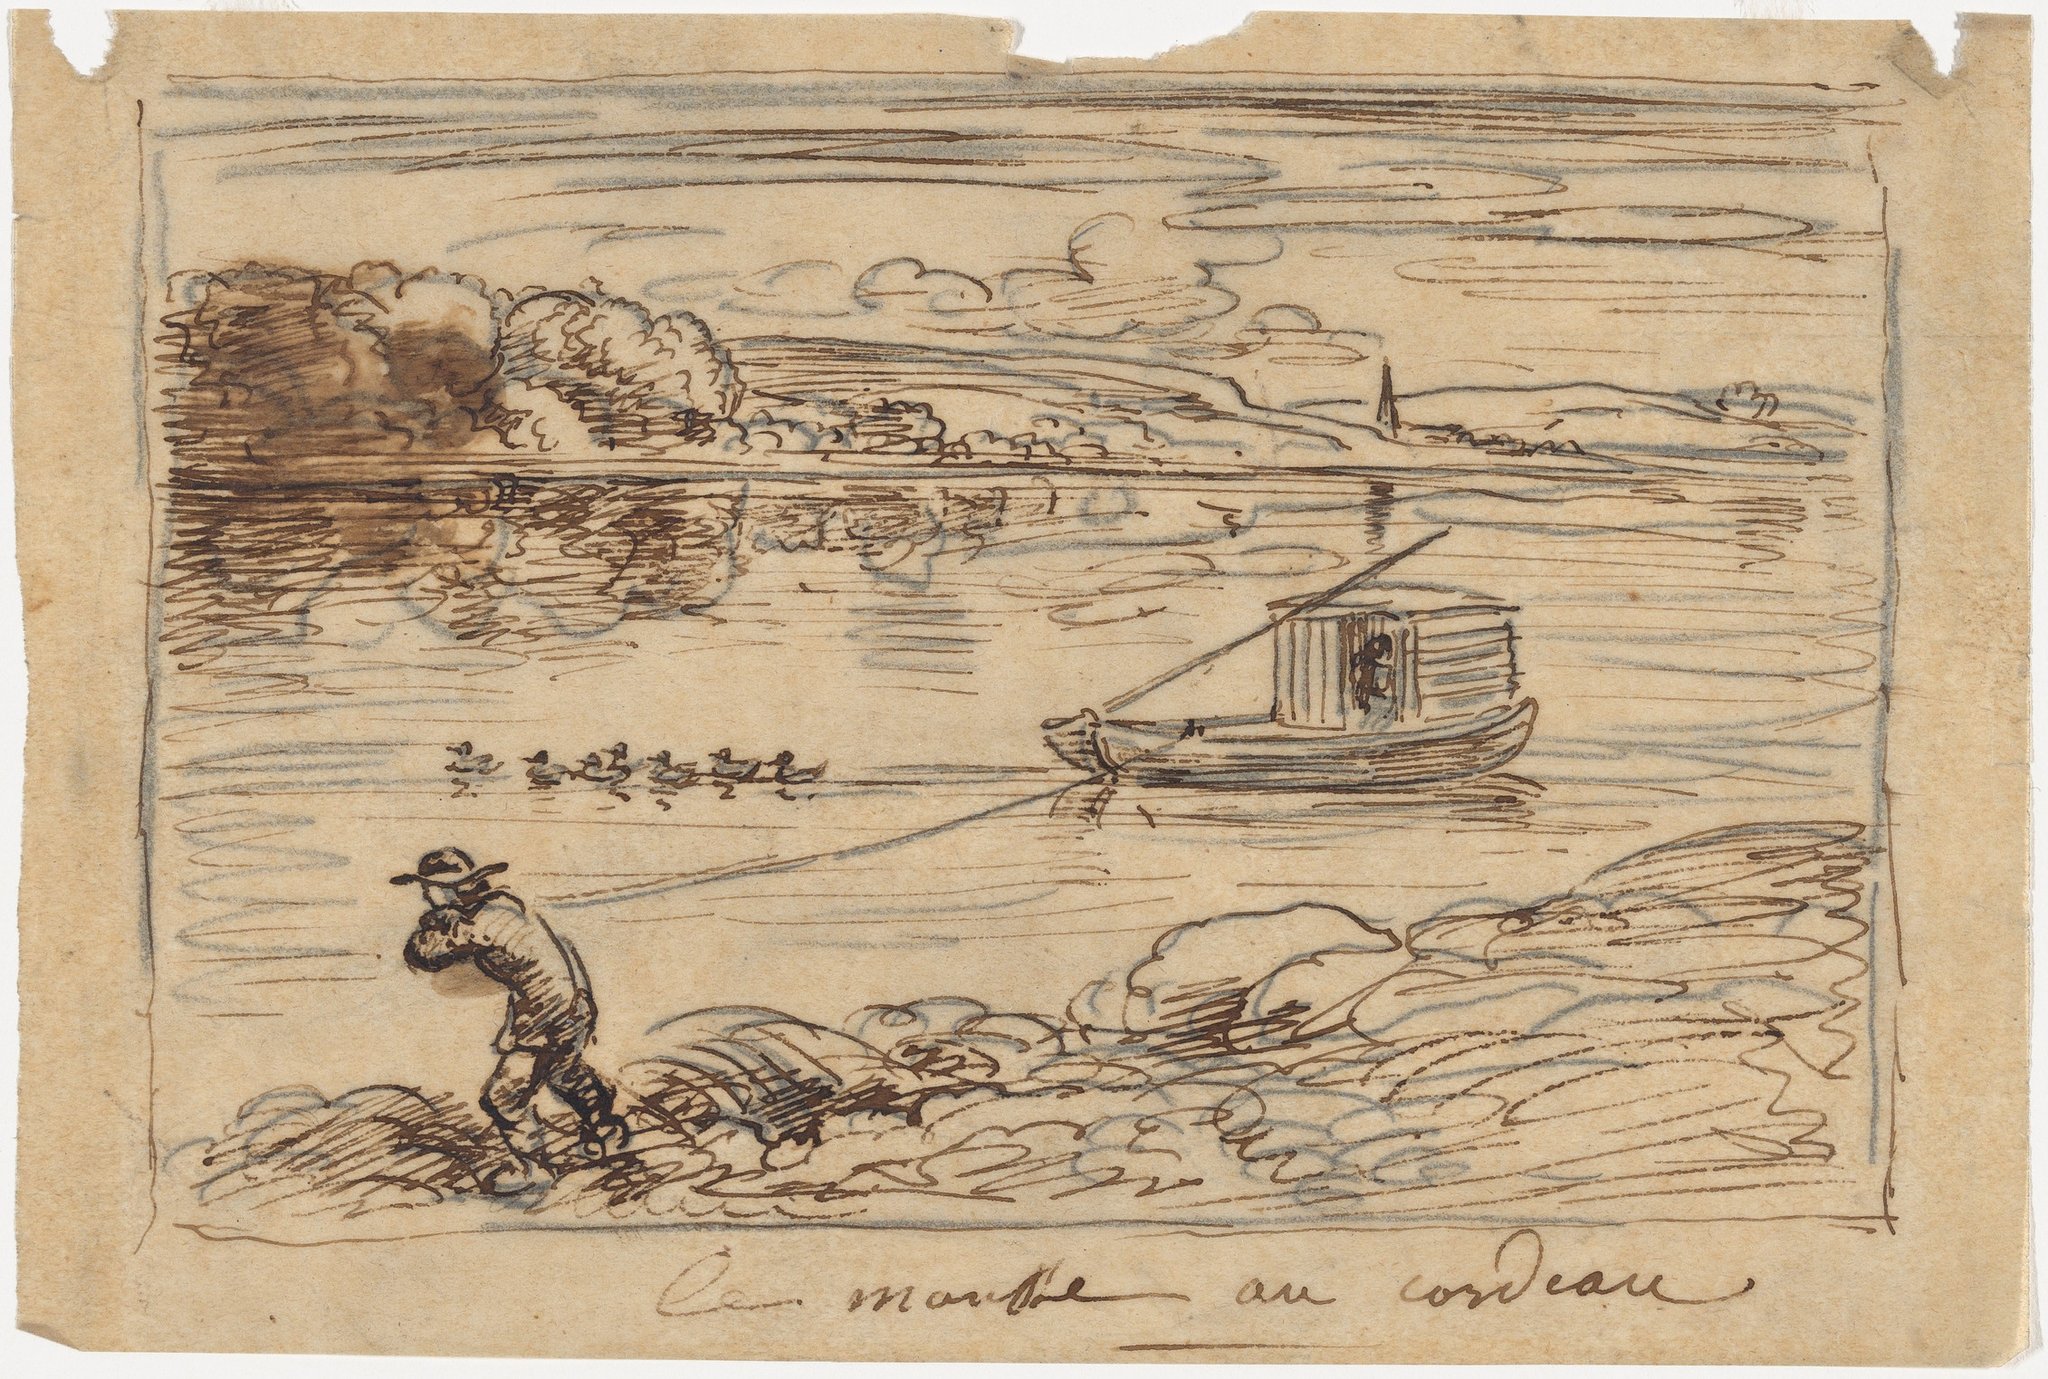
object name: drawing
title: Cabin Boy Hauling the Tow-Rope or Hauling by Rope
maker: charles-françois daubigny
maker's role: artist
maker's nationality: french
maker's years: 1817-1878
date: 1862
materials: graphite, ink, paper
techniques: pen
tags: boys,boats